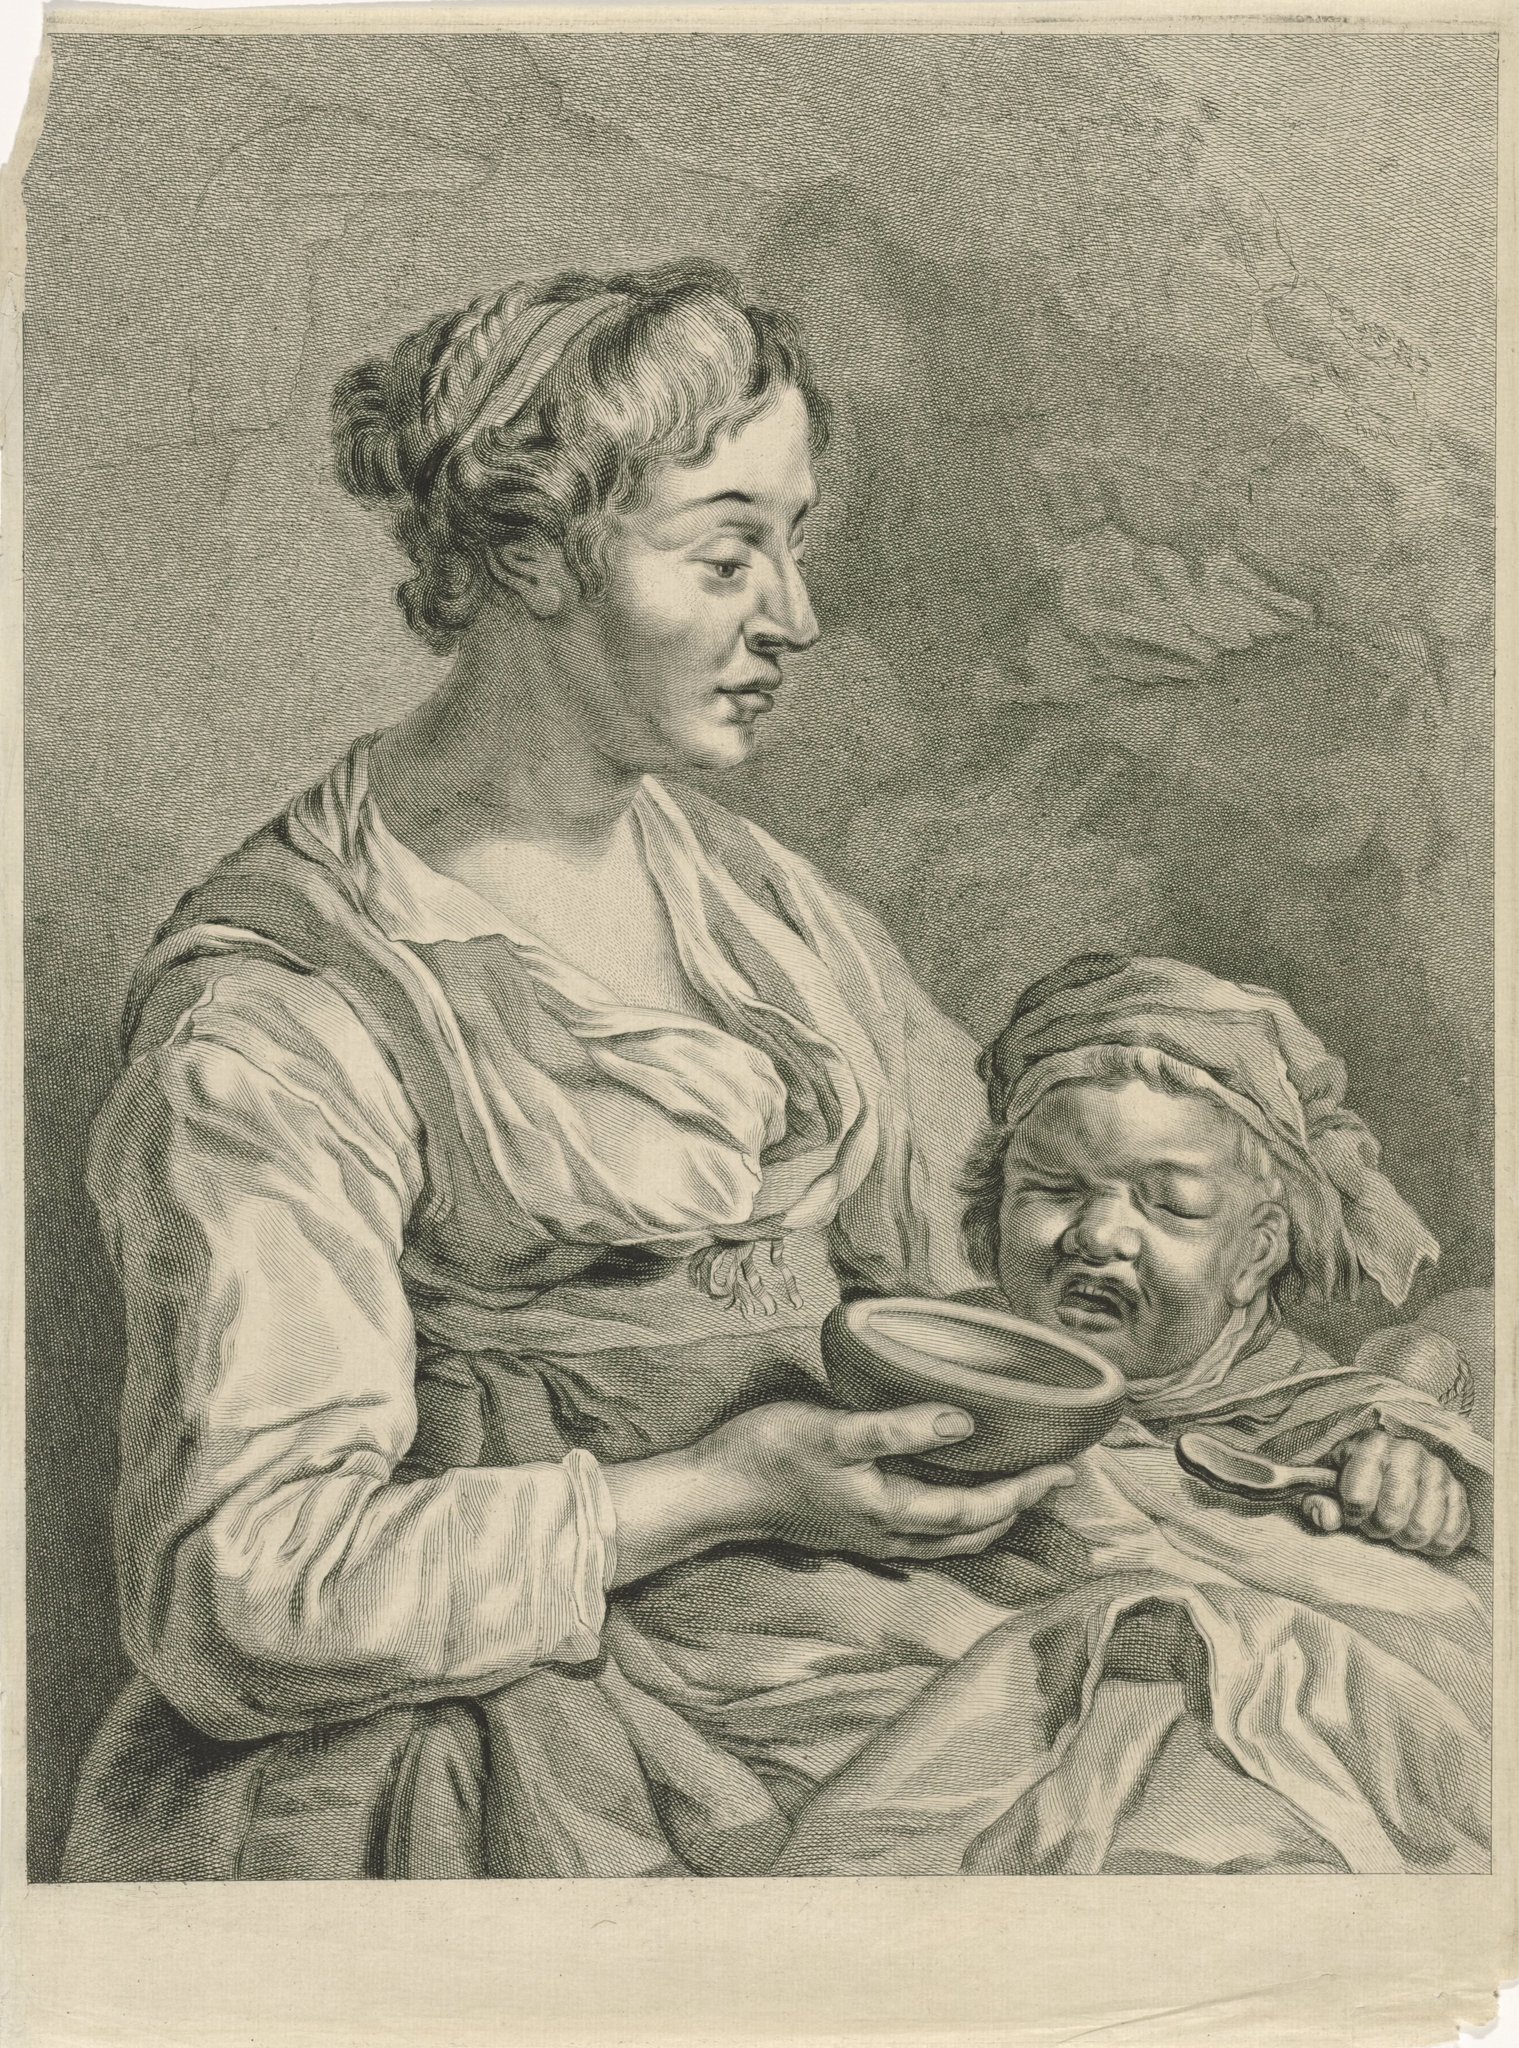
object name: print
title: Moeder geeft haar kind te eten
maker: pieter de mare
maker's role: print maker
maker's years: 1758-1796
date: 1786-1796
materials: paper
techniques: engraving, etching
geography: leiden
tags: feeding a baby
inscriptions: collector's mark: Lugt 240